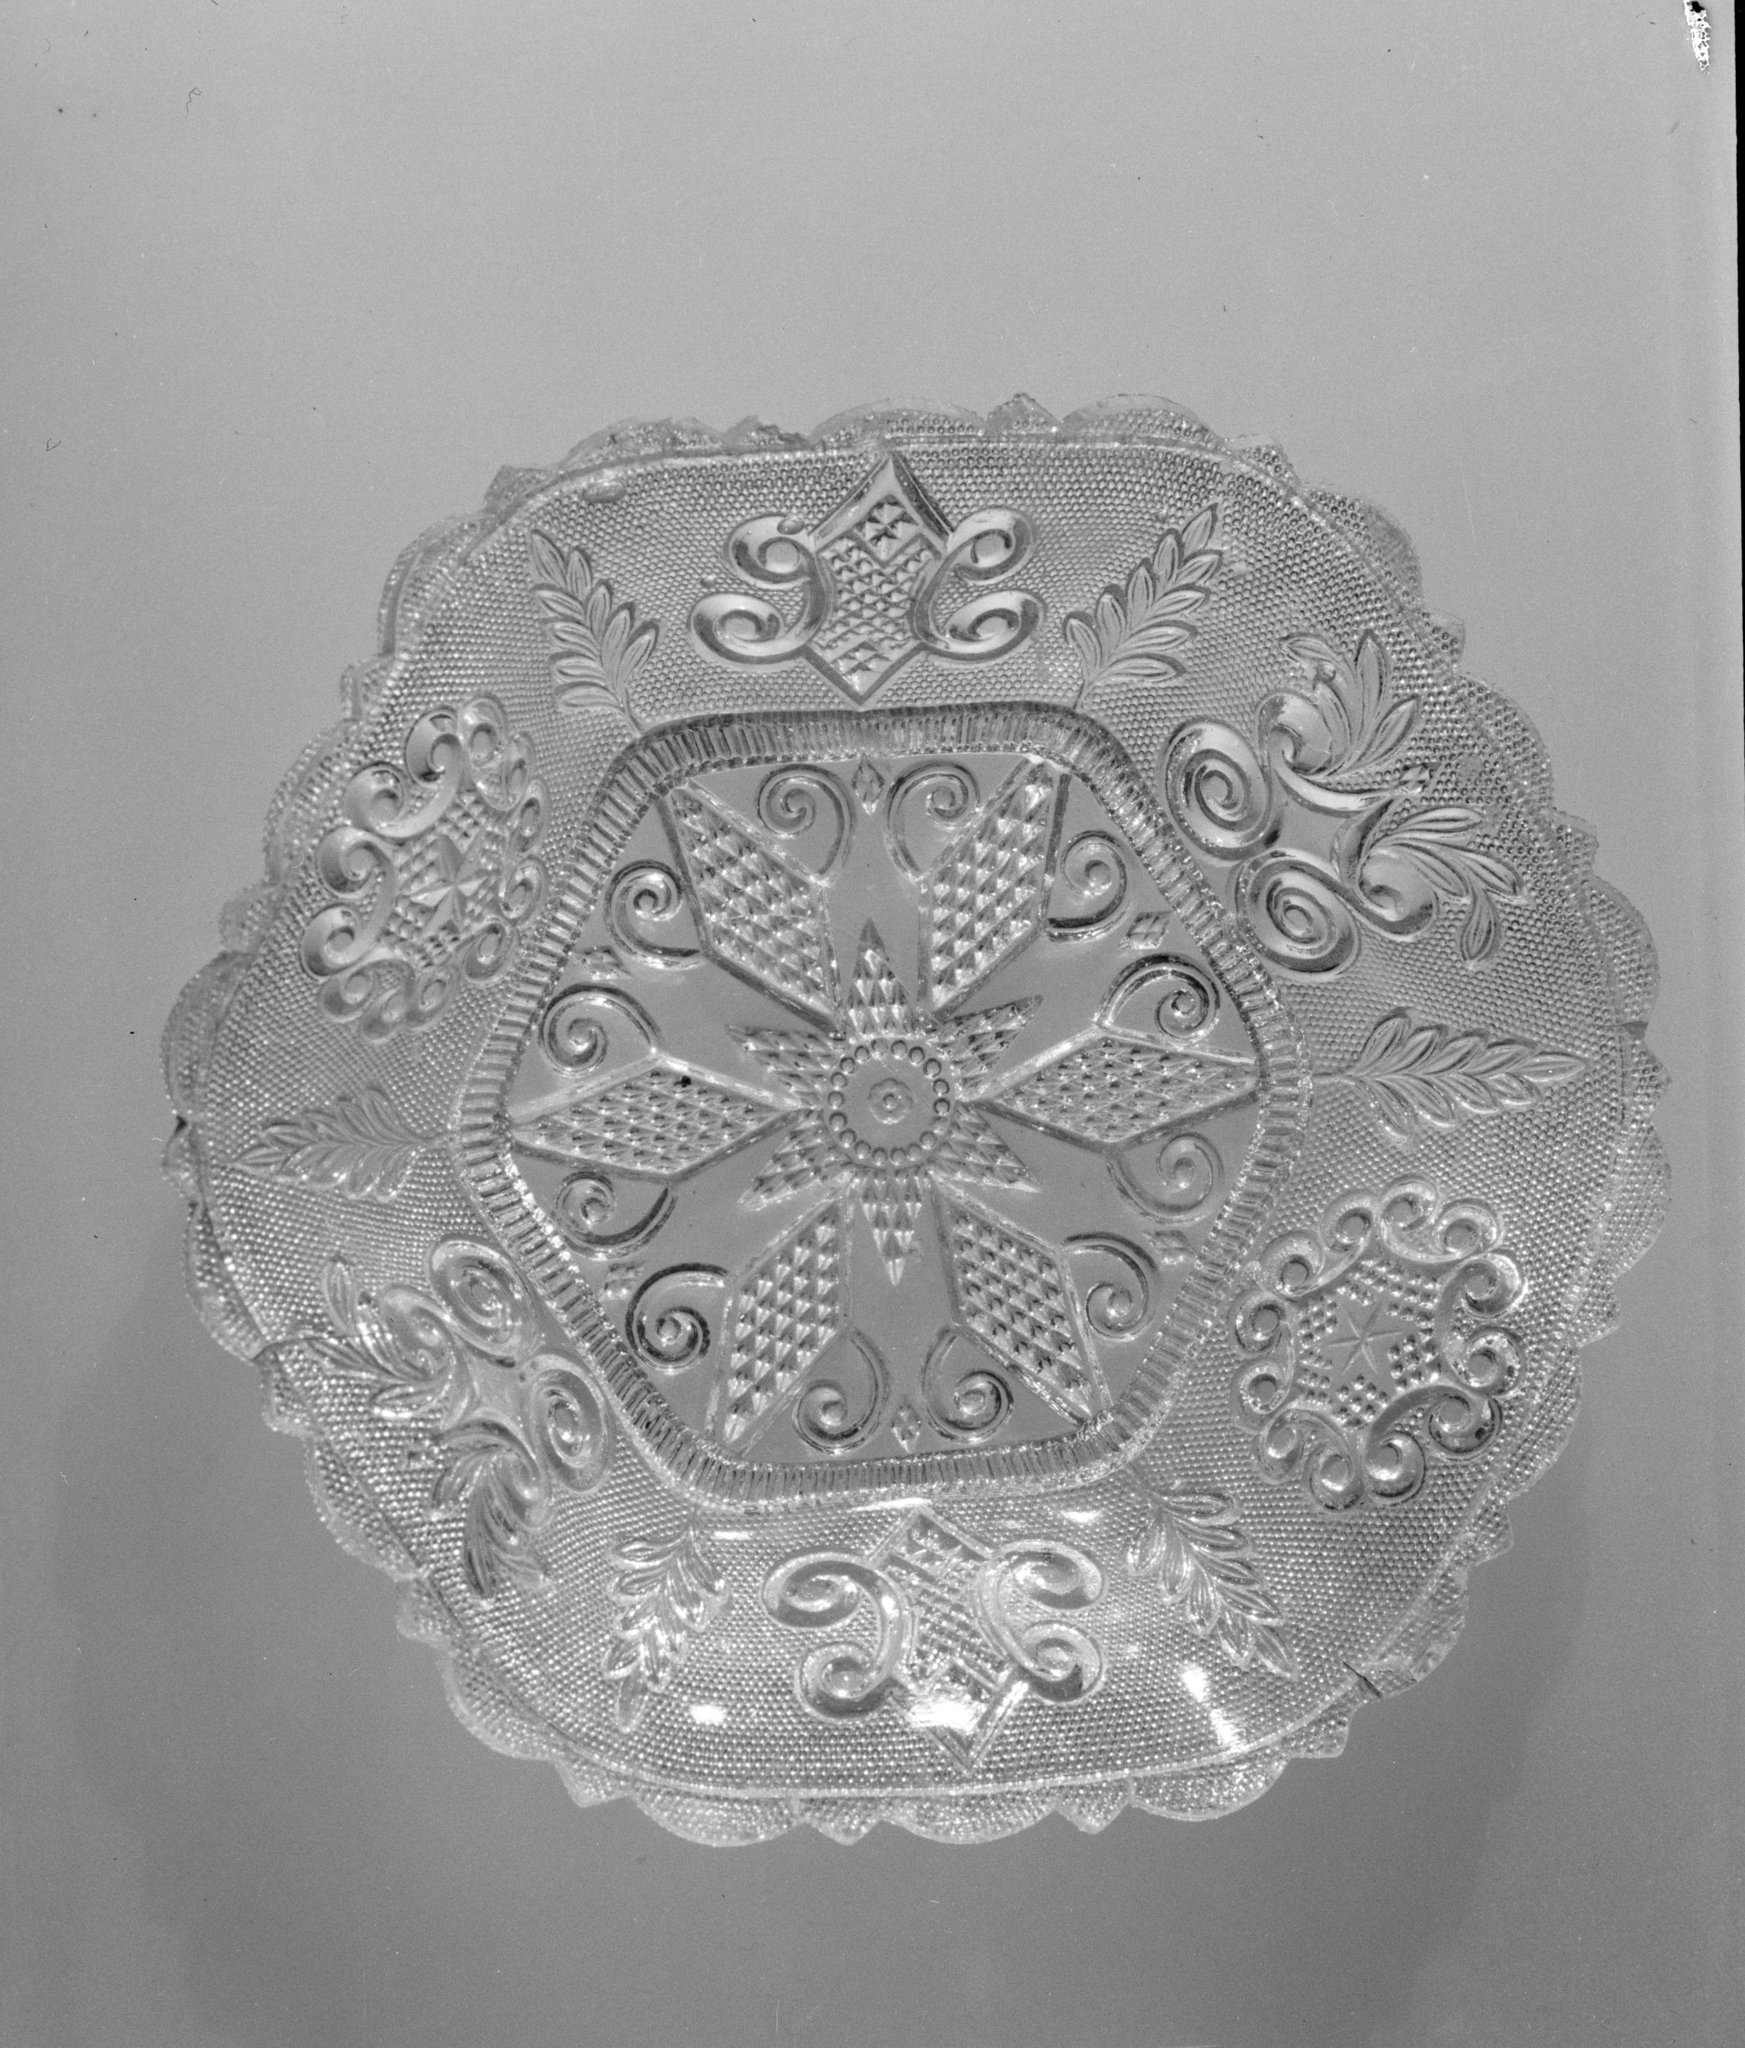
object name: bowl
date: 1835-1850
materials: glass